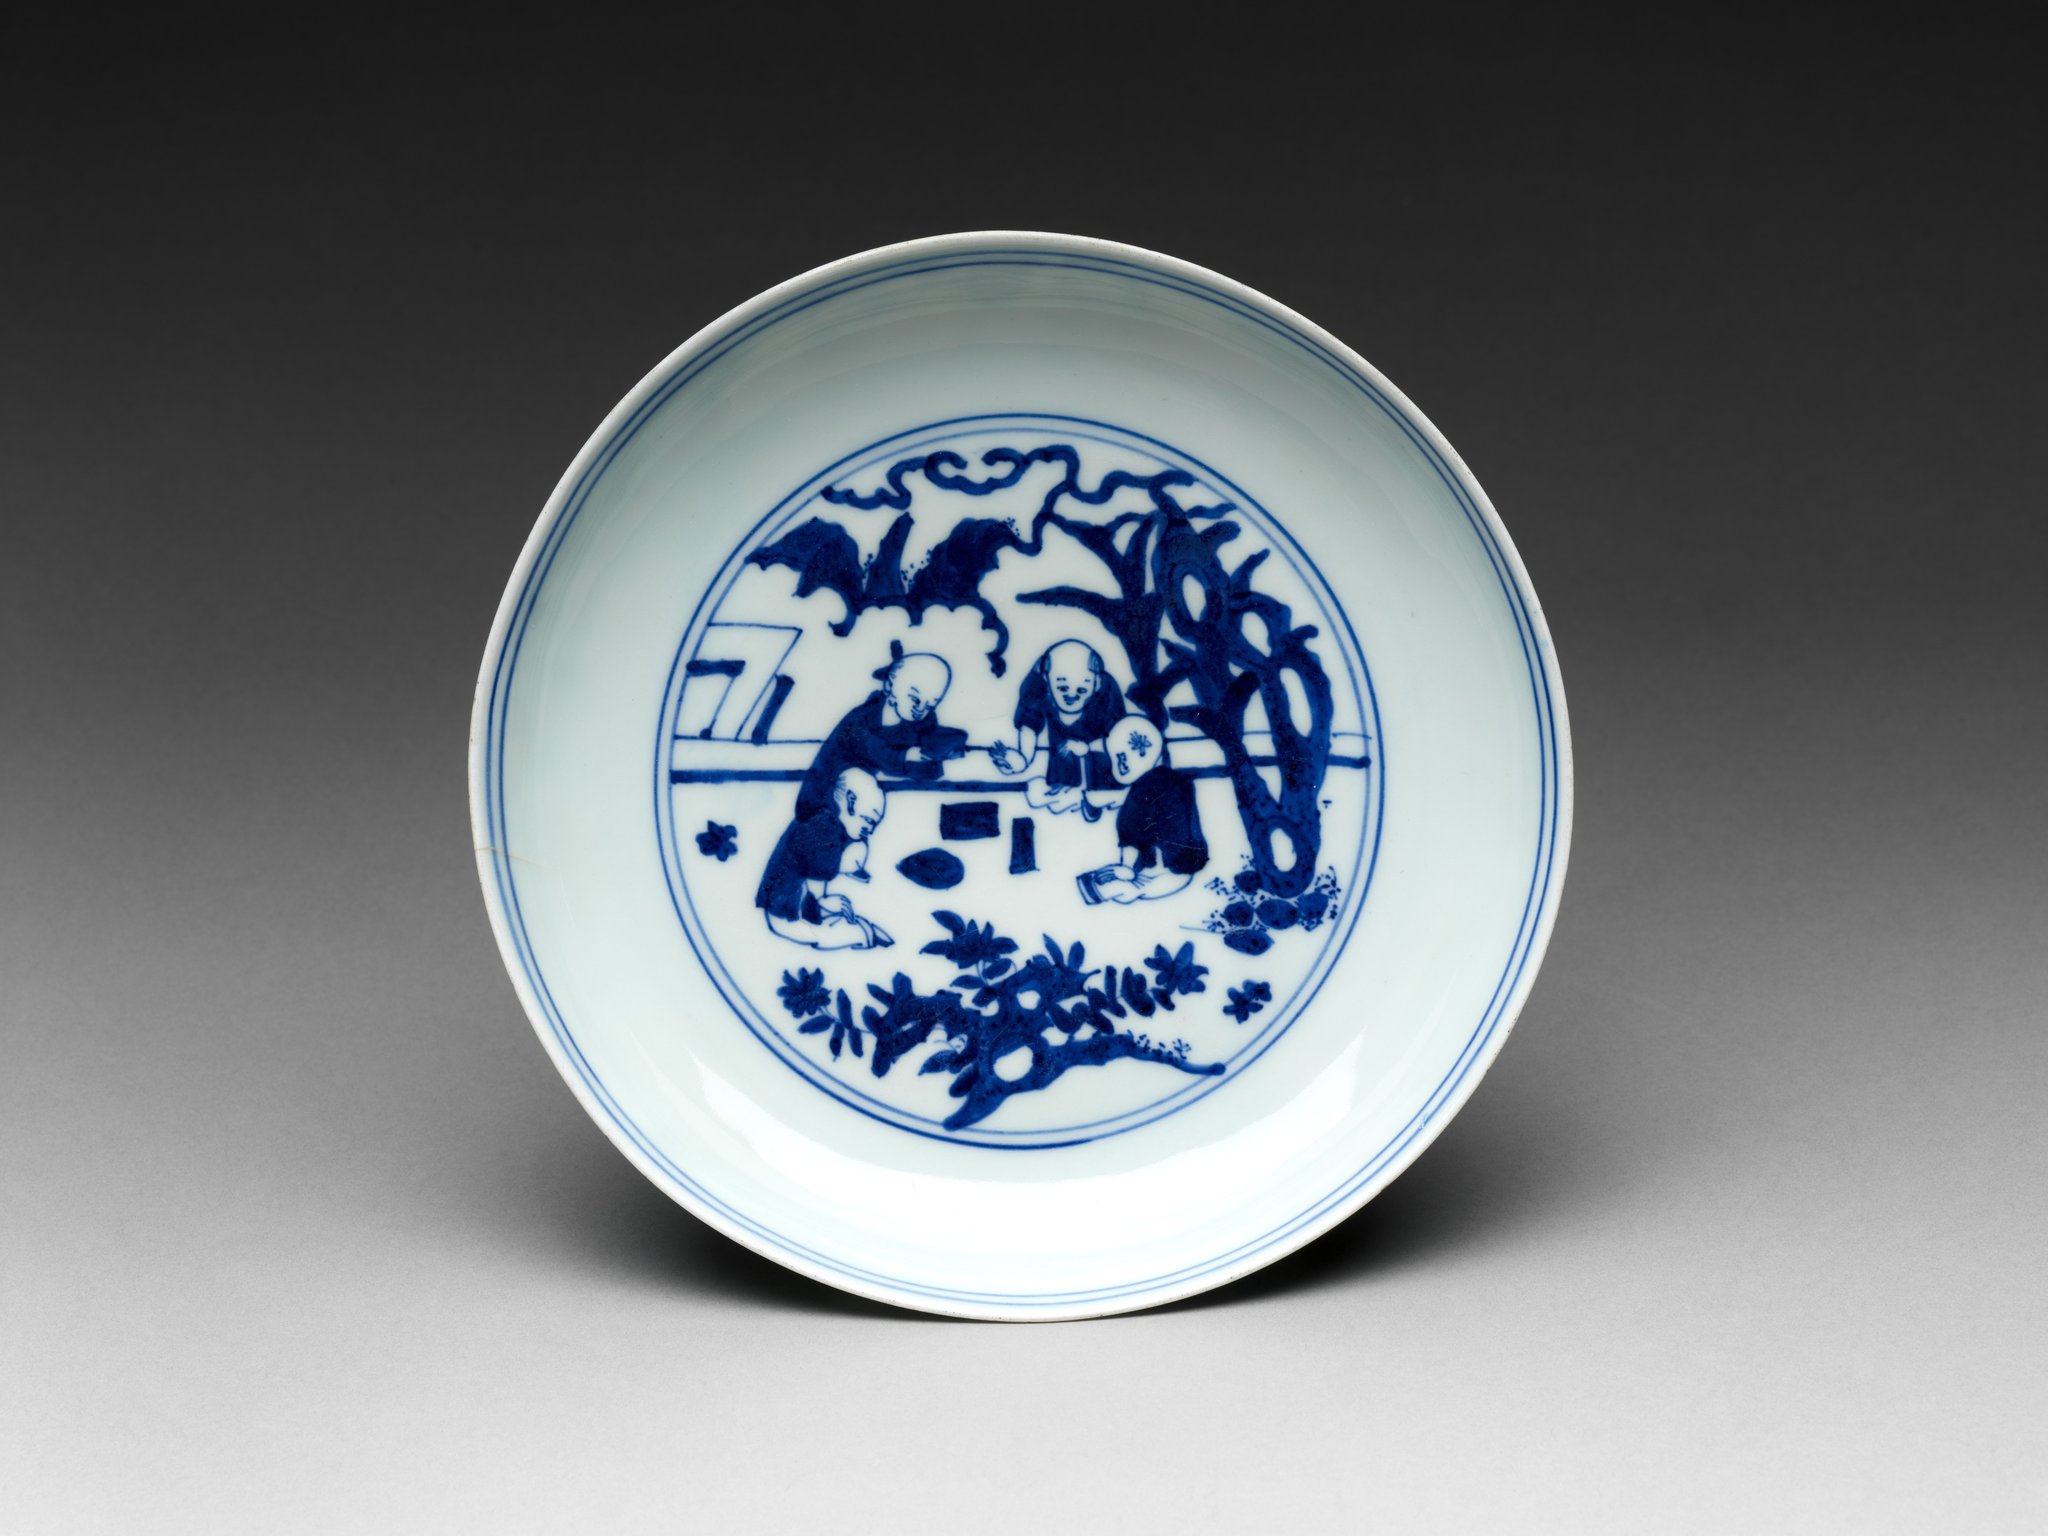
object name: dish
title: Dish with Children in Garden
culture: chinese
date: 1534-1566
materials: cobalt, glaze, porcelain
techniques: painting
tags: gardens,boys,playing